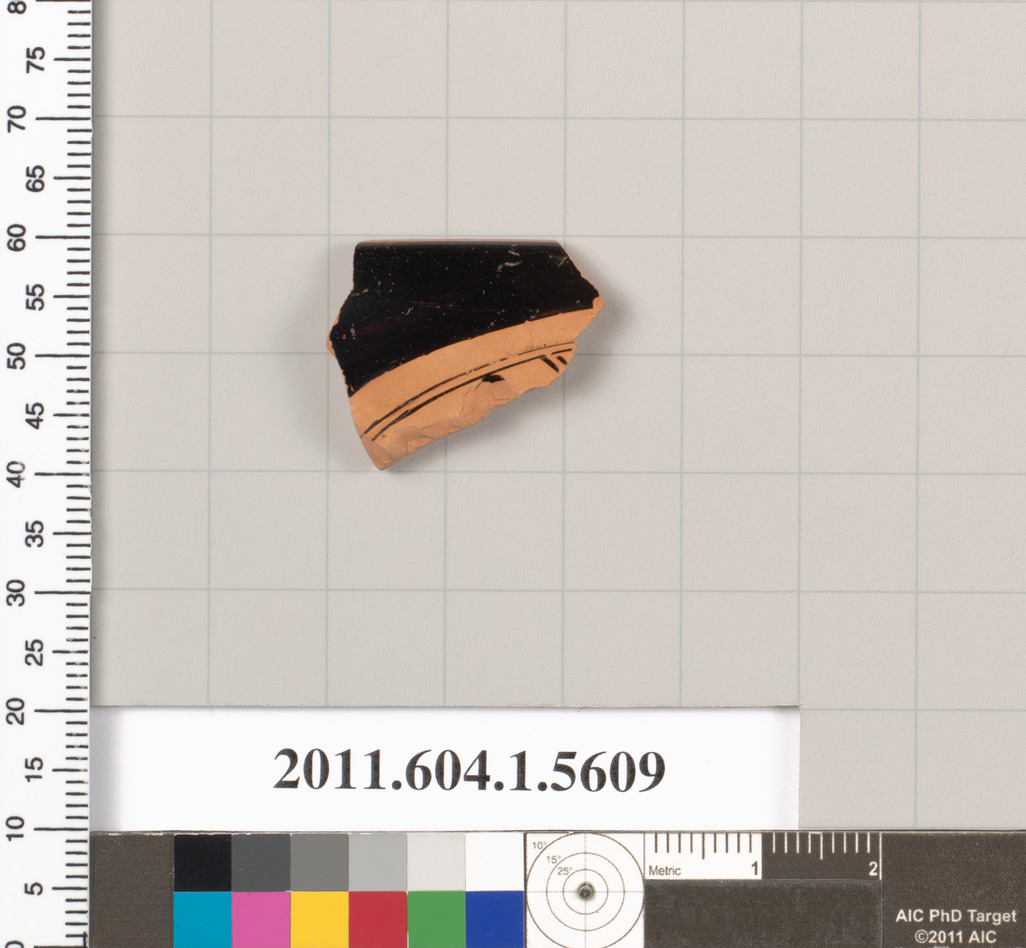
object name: kylix fragment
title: Terracotta rim fragment of a kylix (drinking cup)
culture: greek, attic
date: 520-500 BCE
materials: terracotta